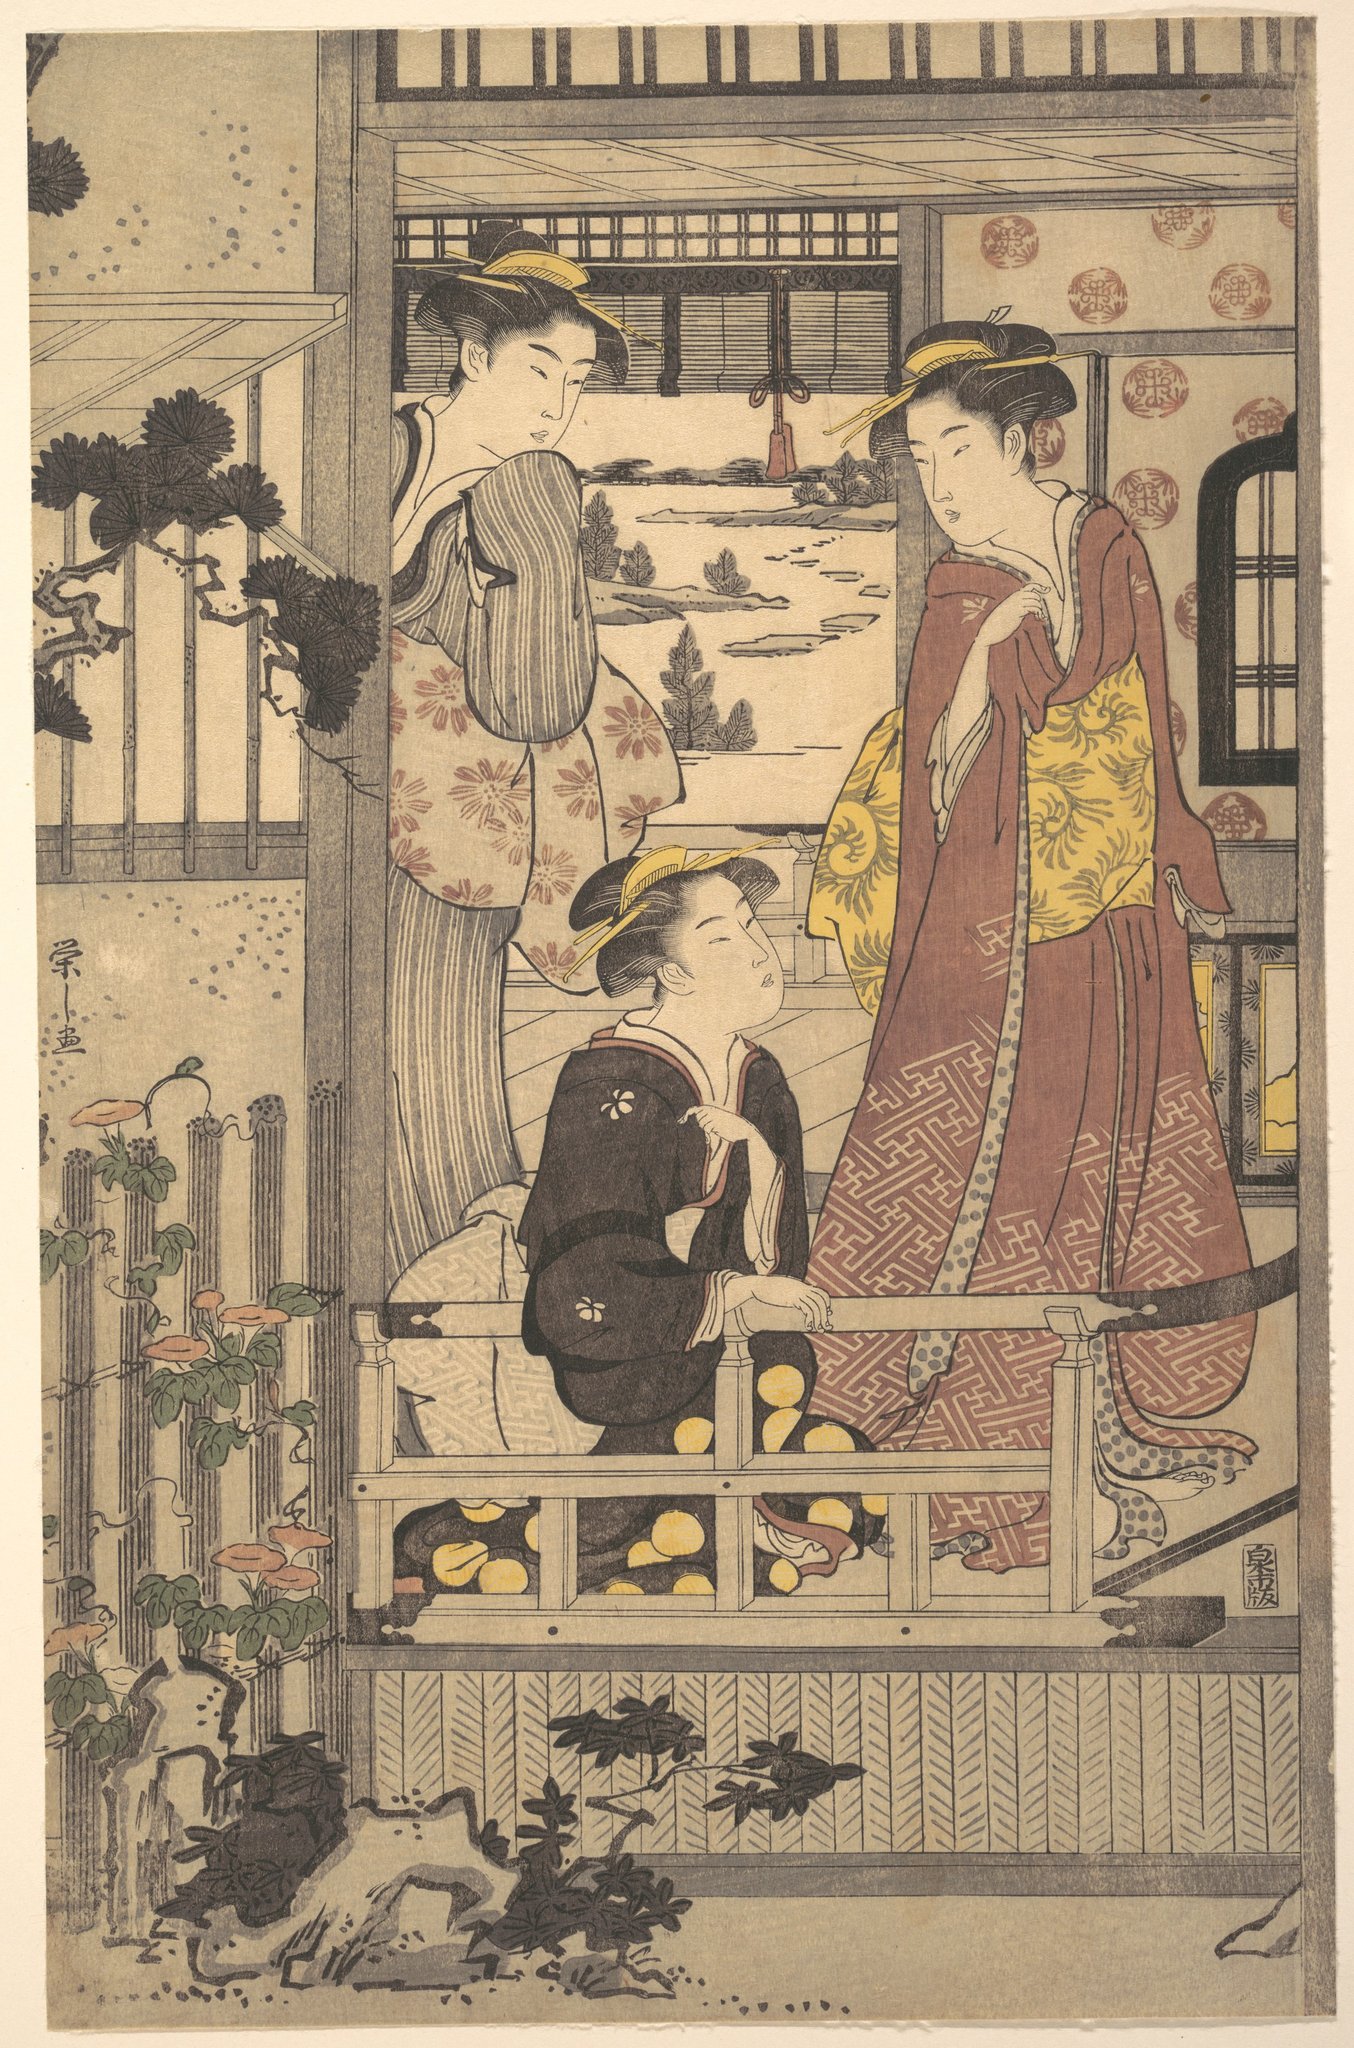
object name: print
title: Three Women on a Veranda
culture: japanese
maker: chōbunsai eishi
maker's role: artist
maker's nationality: japanese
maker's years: 1756-1829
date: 1756-1829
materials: ink, paper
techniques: woodblock print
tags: women